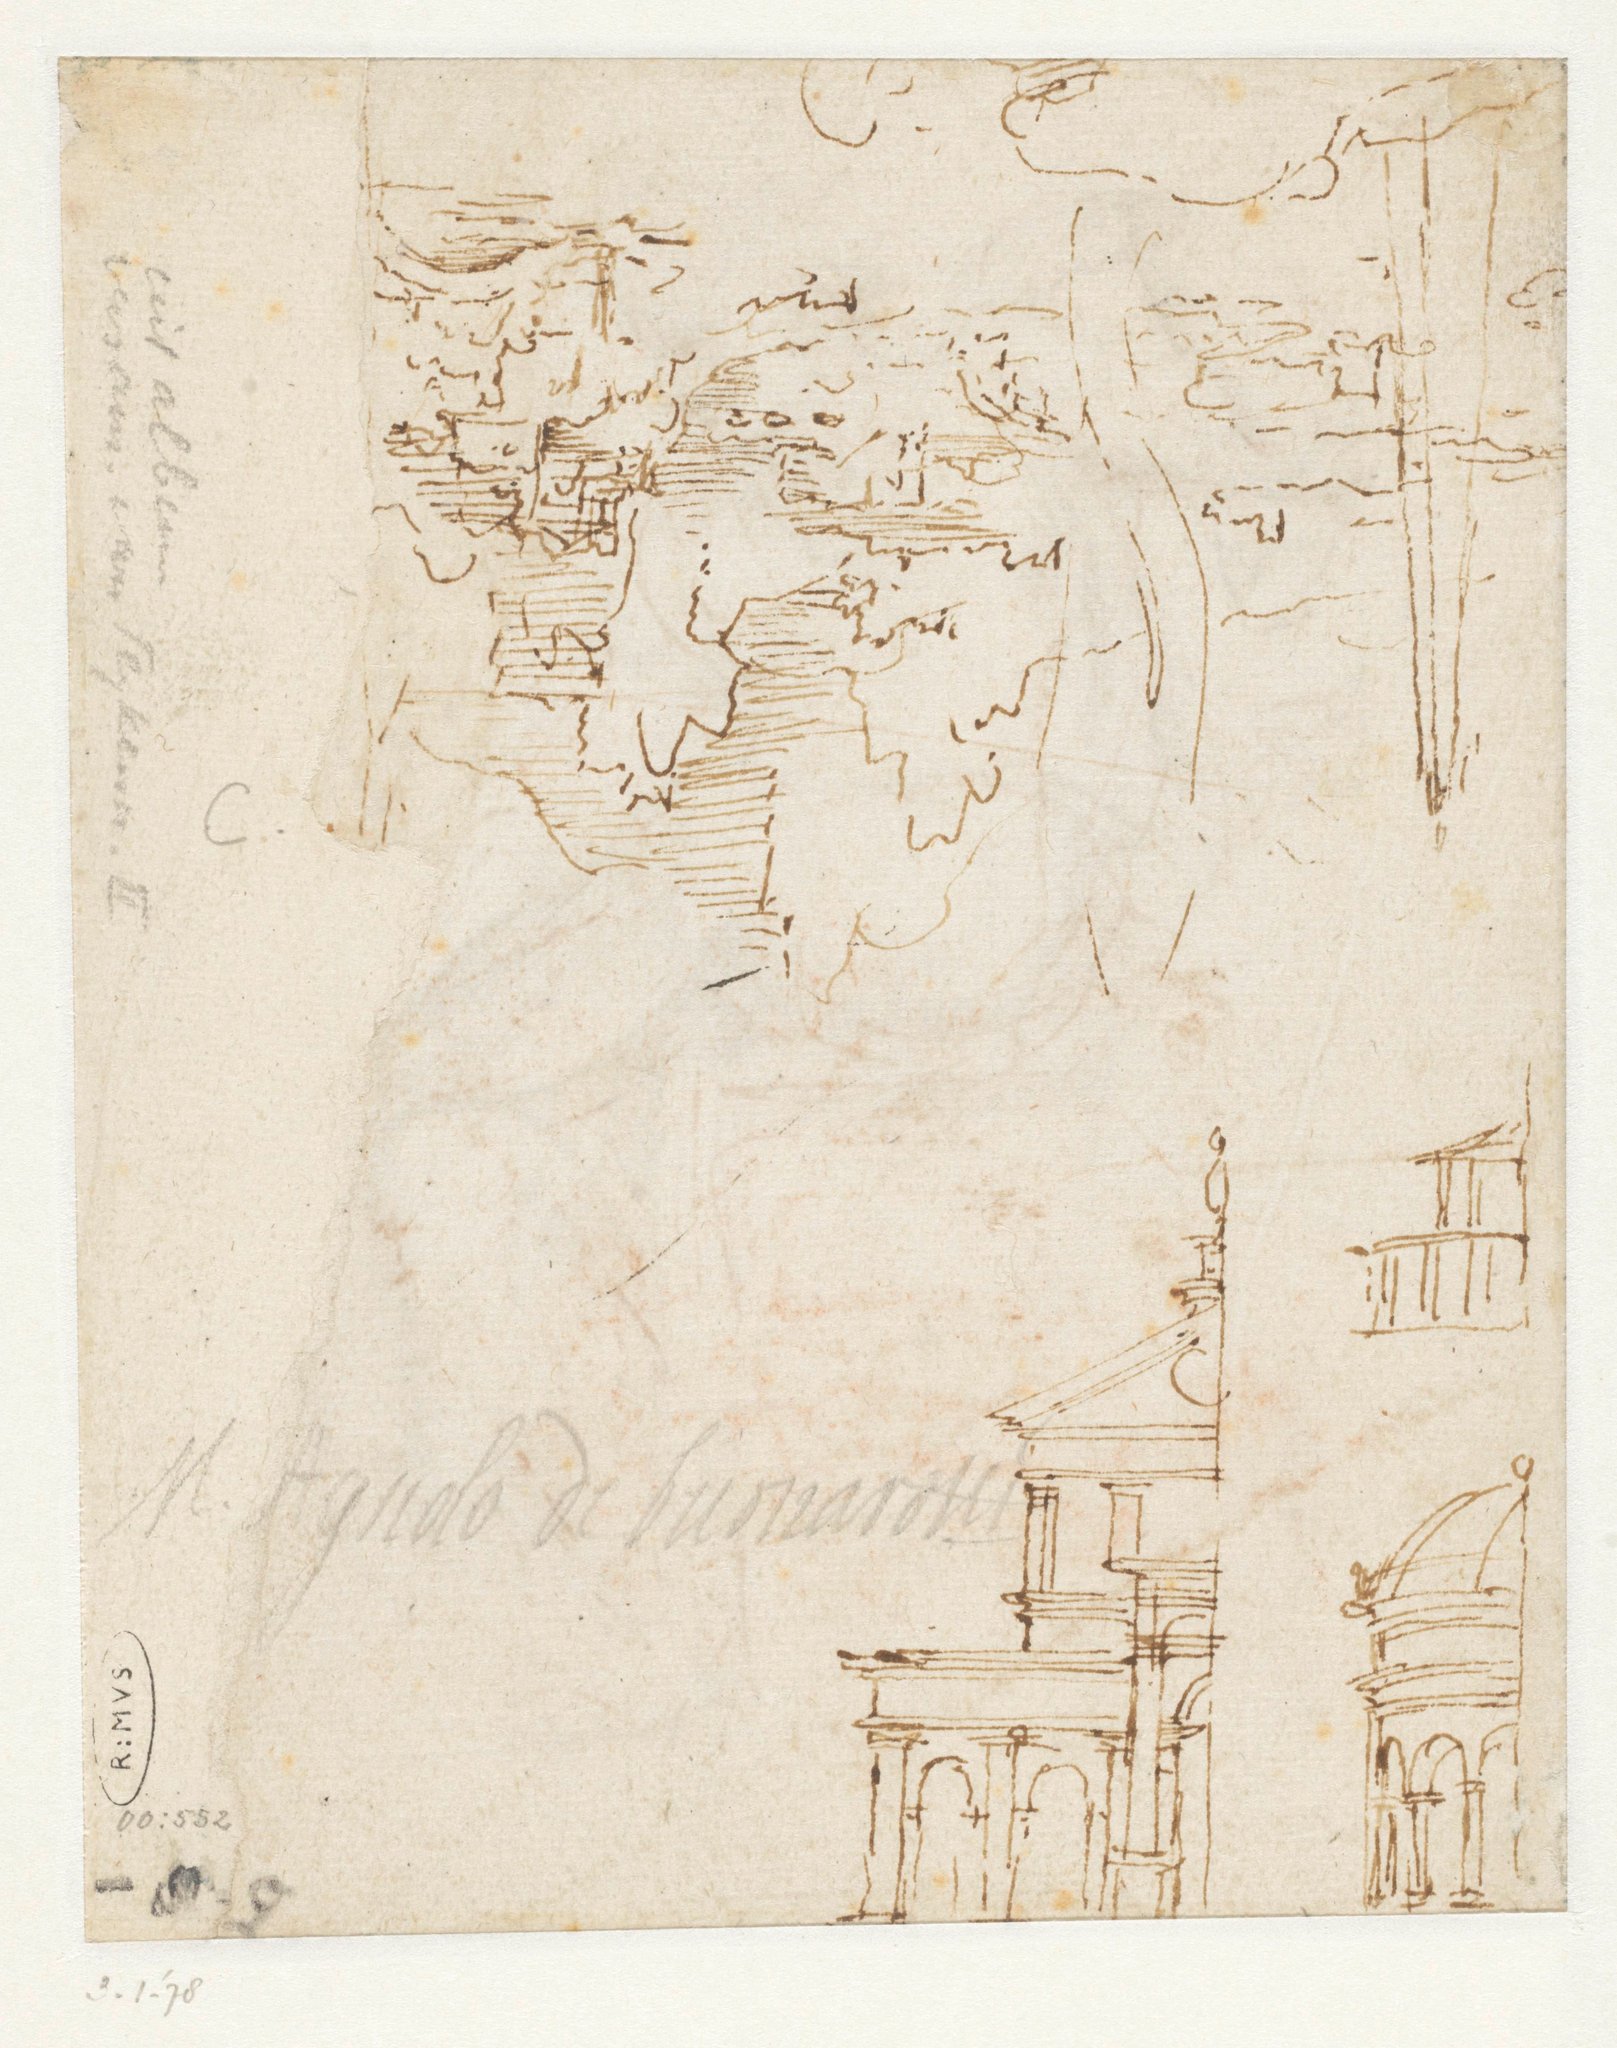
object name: drawing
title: Twee architectuurstudies en een landschap met een obelisk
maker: martinus van heemskerck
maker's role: draughtsman, painter, print maker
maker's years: 1498-1574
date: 1536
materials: ink, paper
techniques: pen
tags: obelisk, needle, architectural representations in general, landscape with ruins